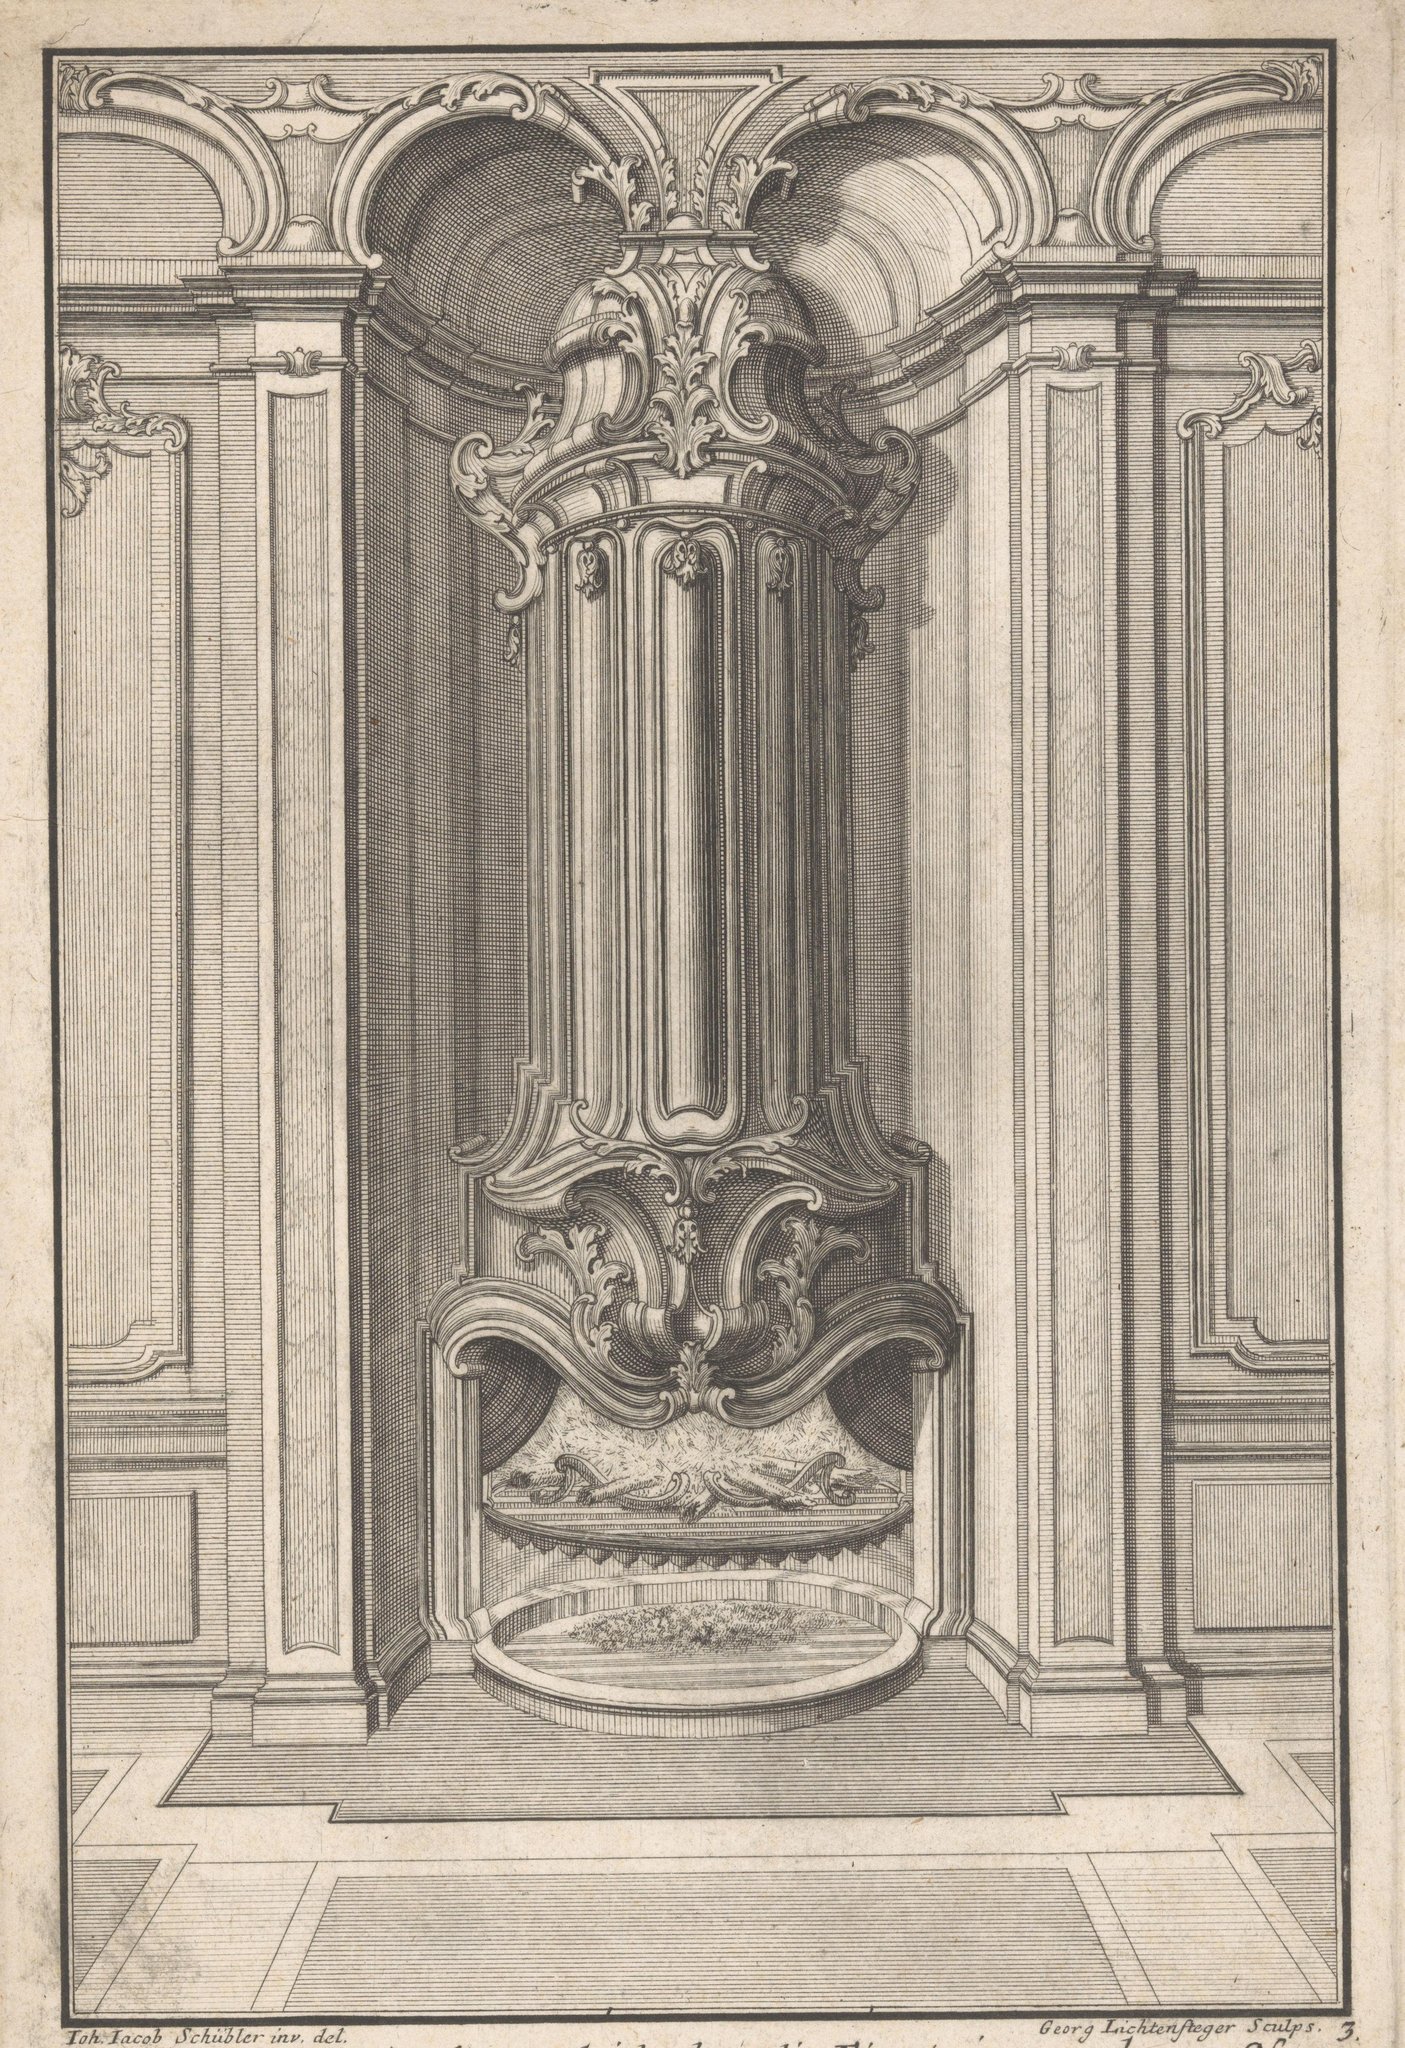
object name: print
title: Johann Jacob Schüblers Vierzehende Ausgab seines vorhabenden Wercks, Worinnen vorgestellet werden Neu-erfundene Camine und ausserordentliche Stuben-Ofen (...)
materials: paper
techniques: engraving, etching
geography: augsburg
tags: rocaille ornament, open hearth, fire-place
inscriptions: collector's mark: Lugt 2760, collector's mark: Lugt 2228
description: Prent uit: Schübler, Johann Jacob. Erste [-Zwanzigste] Ausgabe seines vorhabenden Wercks (...). Augsburg: Wolf, erven Jeremias, [na 1724]